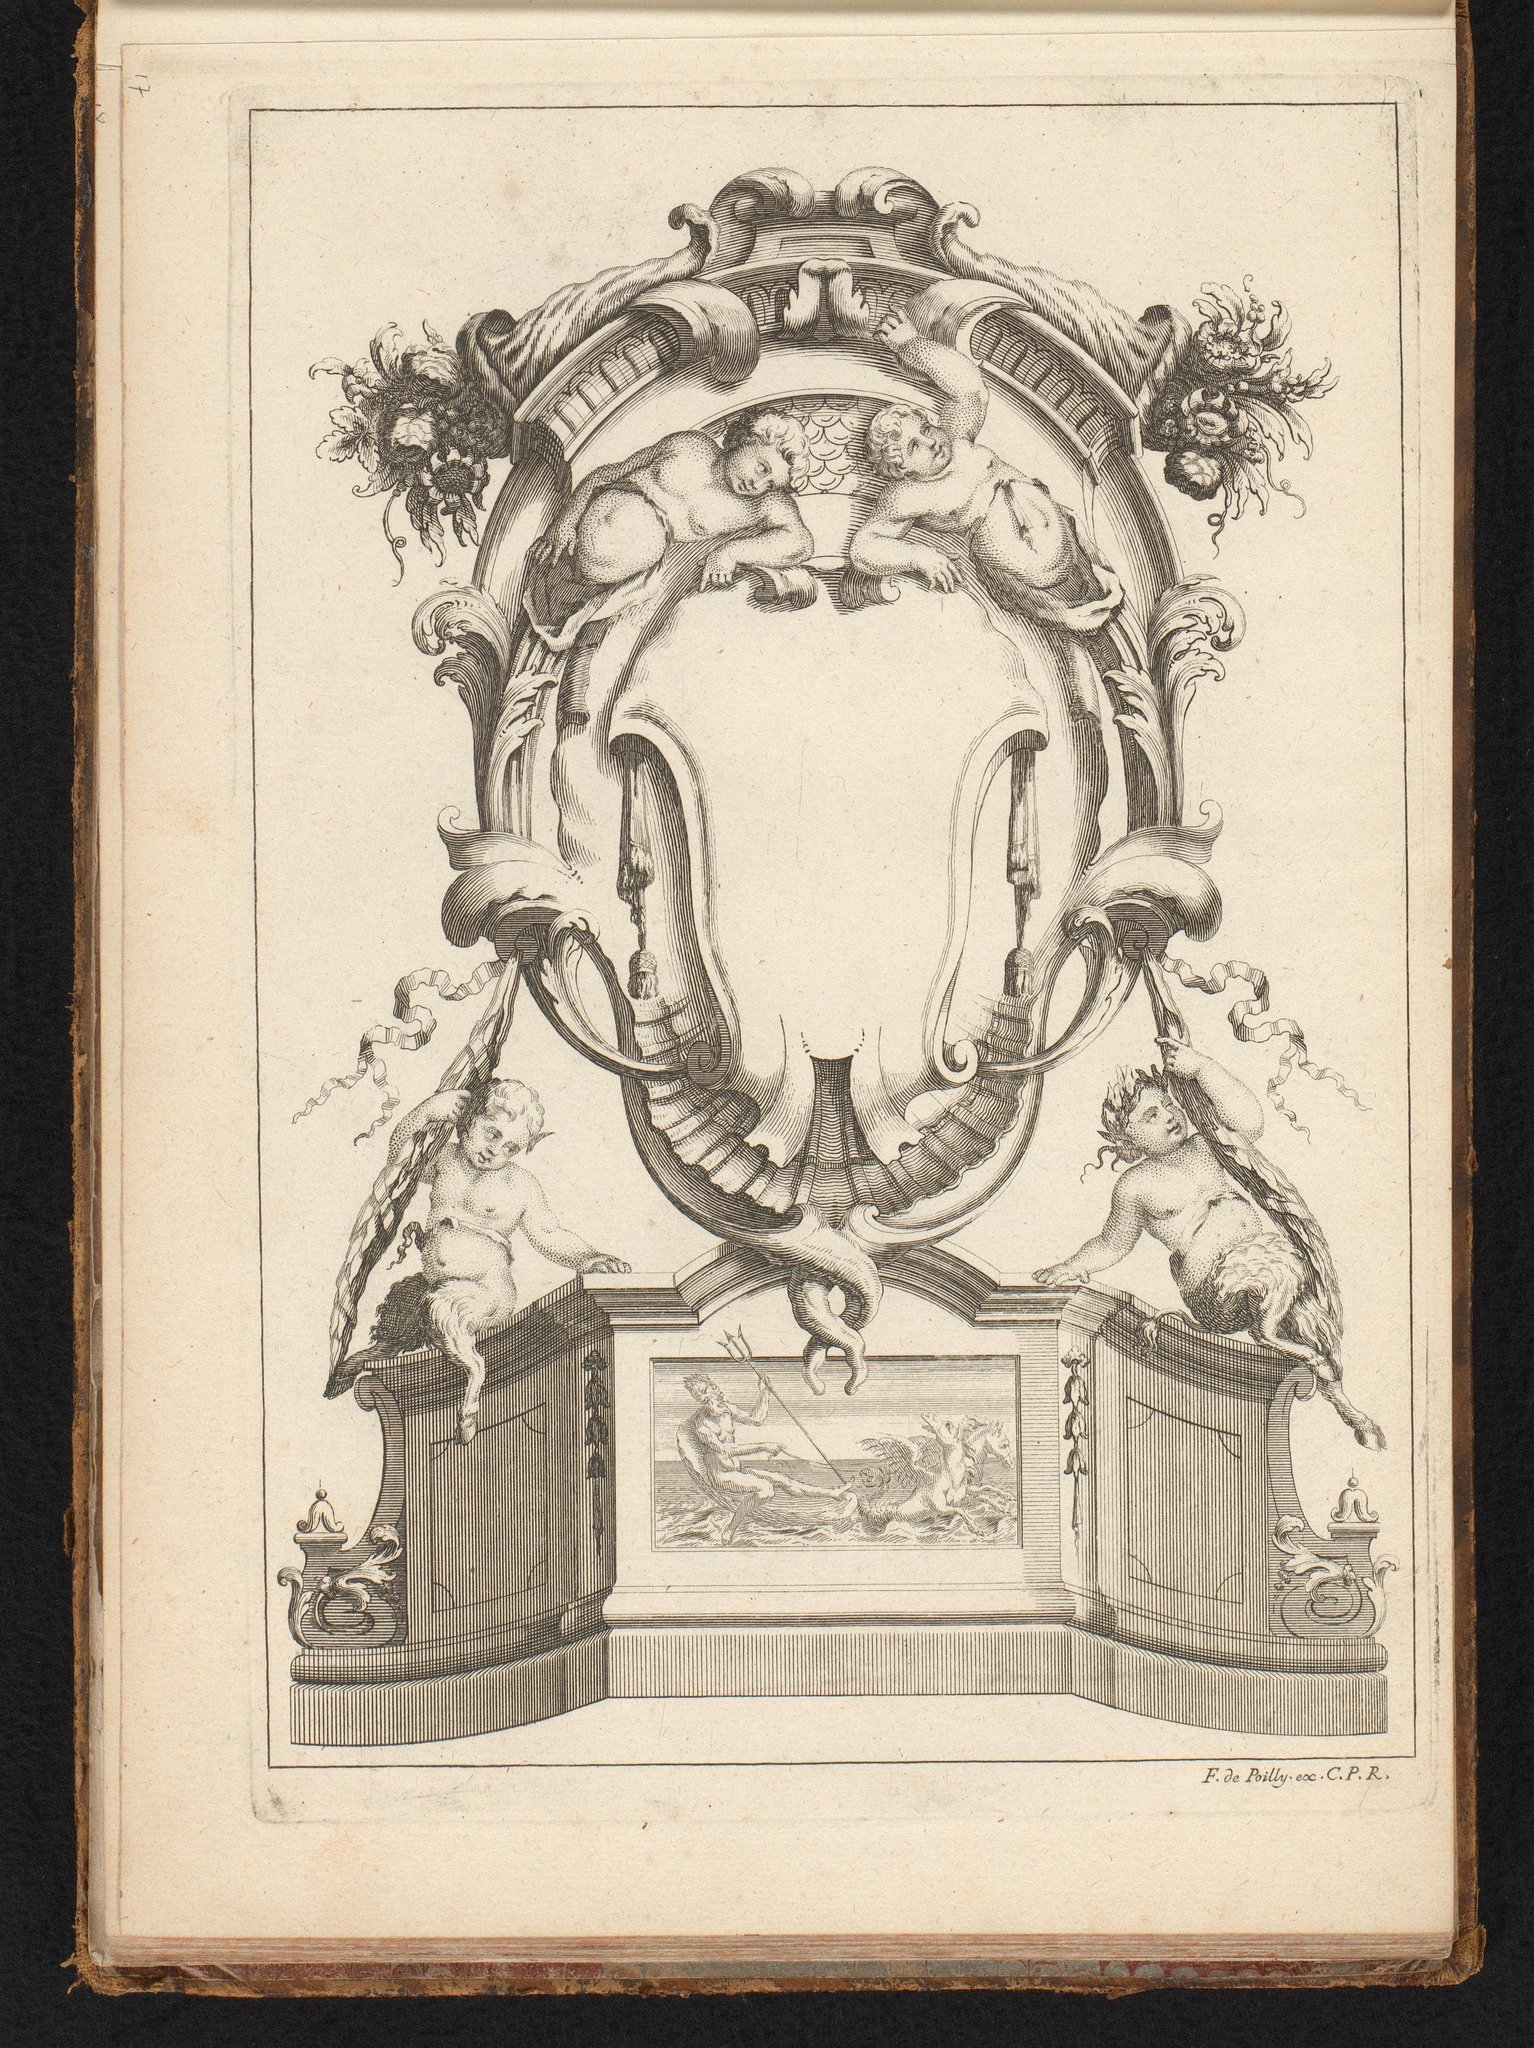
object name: ornament print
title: Cartouche met jonge saters en hoornen des overvloeds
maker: Anonymous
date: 1682-1723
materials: paper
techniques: etching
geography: france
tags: (story of) neptune (poseidon), 'cornucopia', horn of plenty, satyr(s) (in general), ornament ~ cartouche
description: Prent maakt deel uit van een serie van zes prenten.